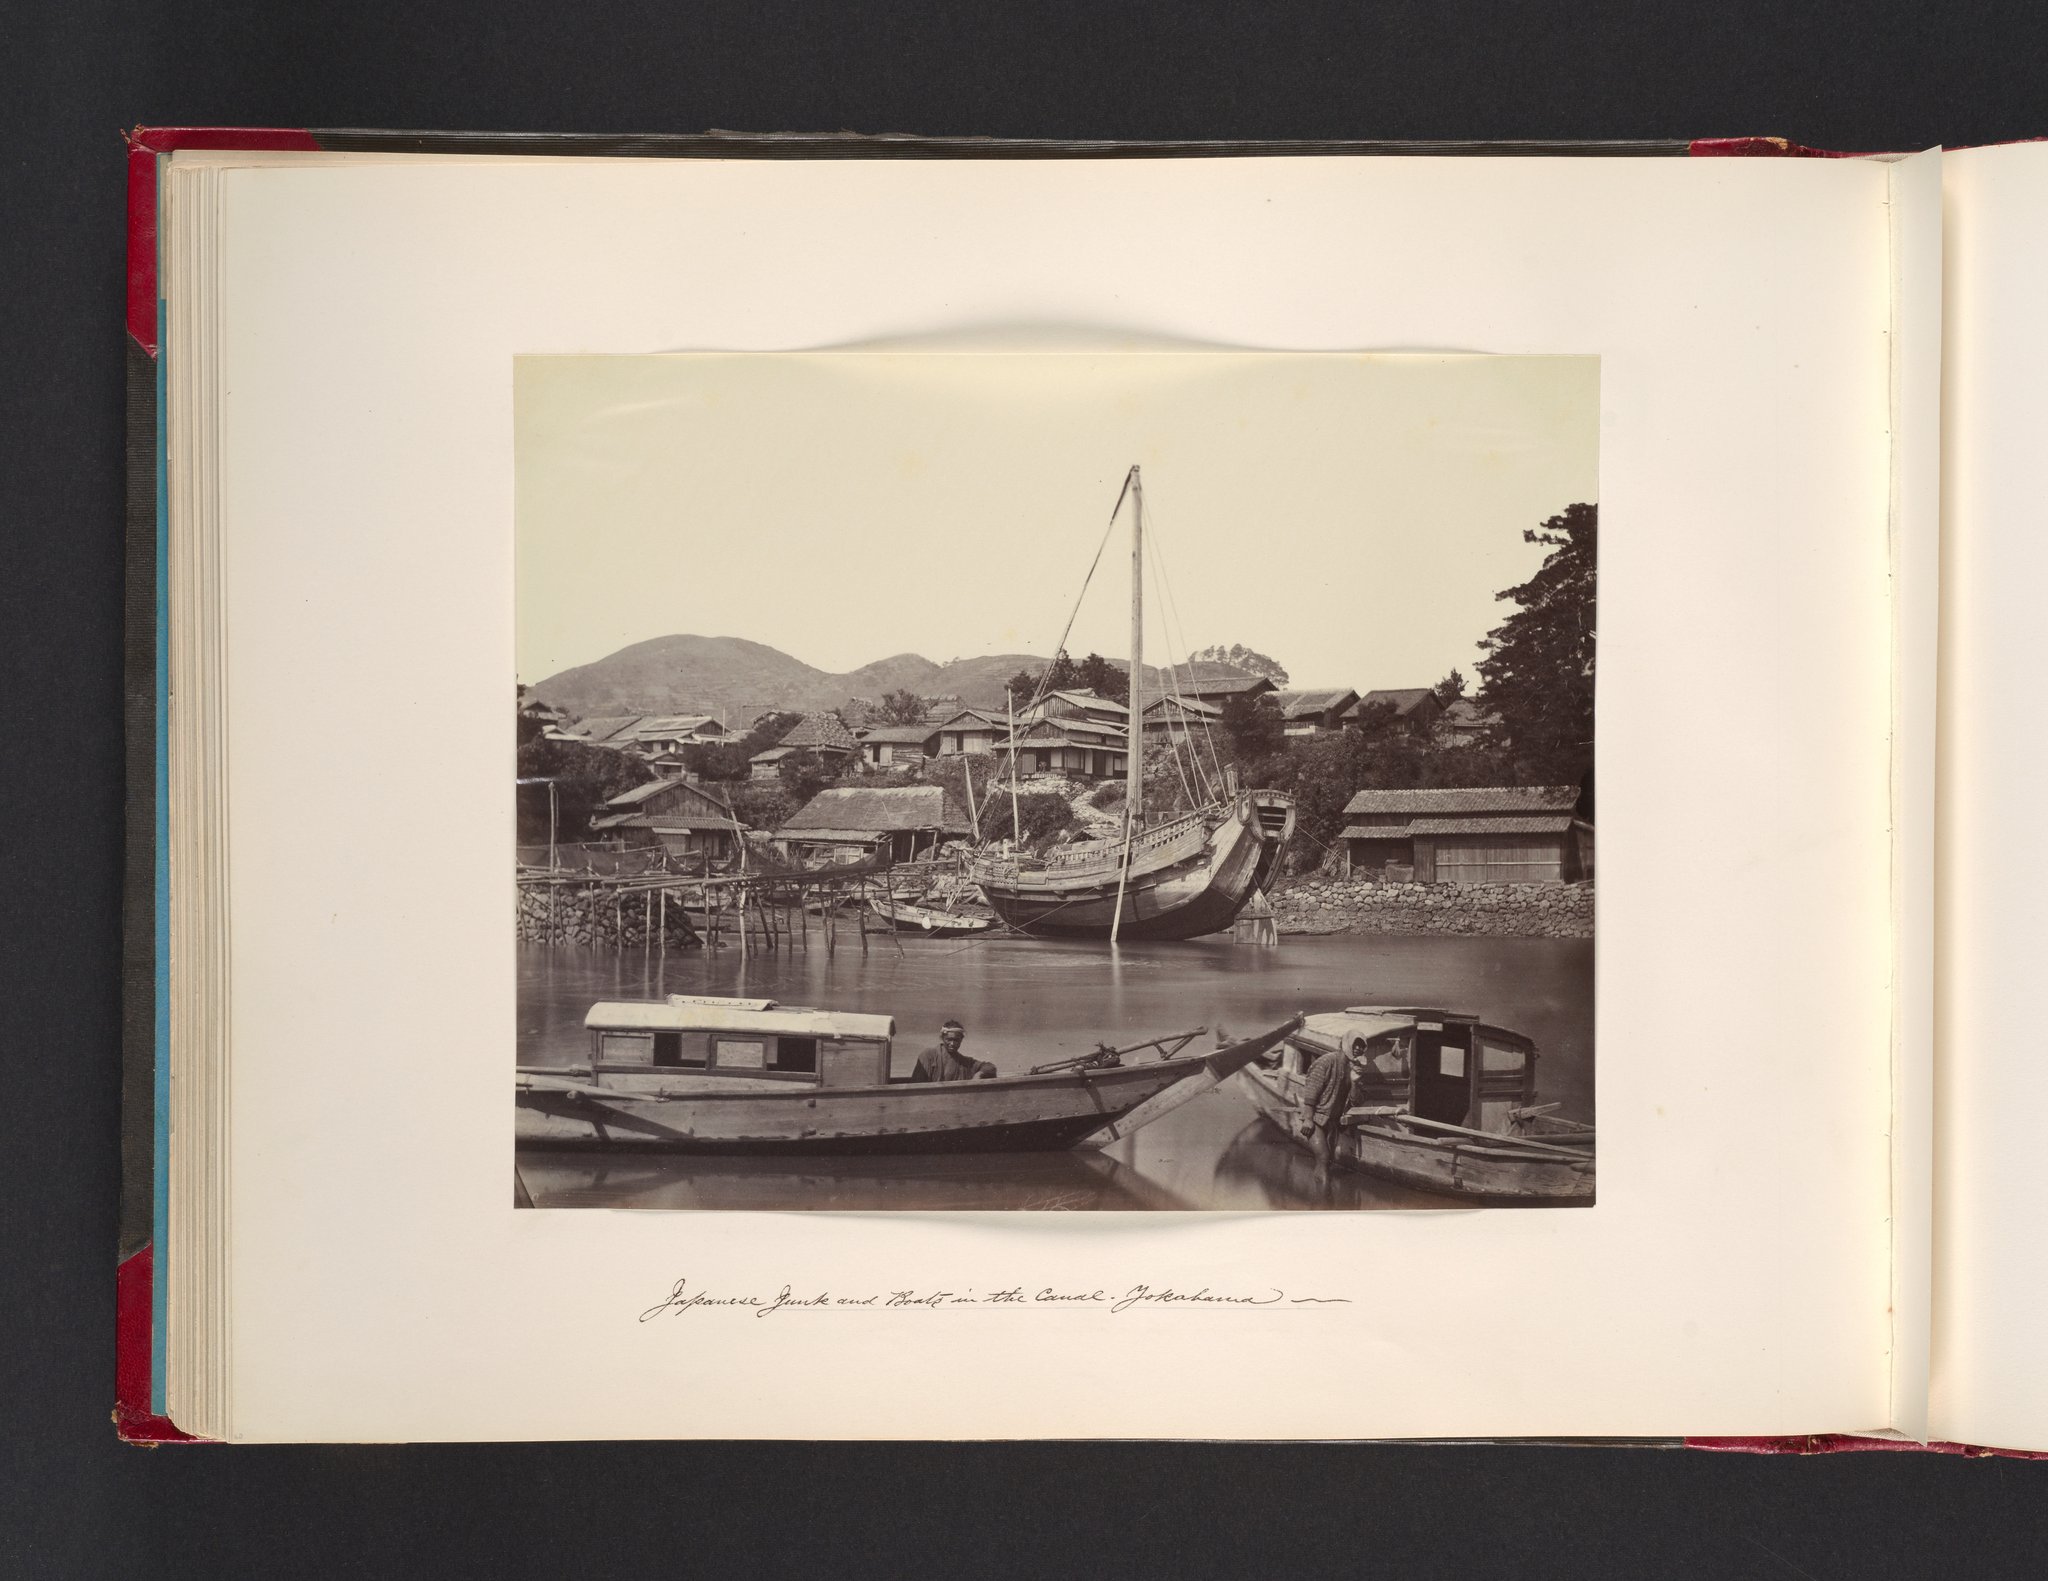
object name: photograph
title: Japanese Junk and Boats in the Canal, Yokohama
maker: john thomson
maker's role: artist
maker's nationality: british, scottish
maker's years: 1837-1921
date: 1865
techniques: albumen silver print, glass negative